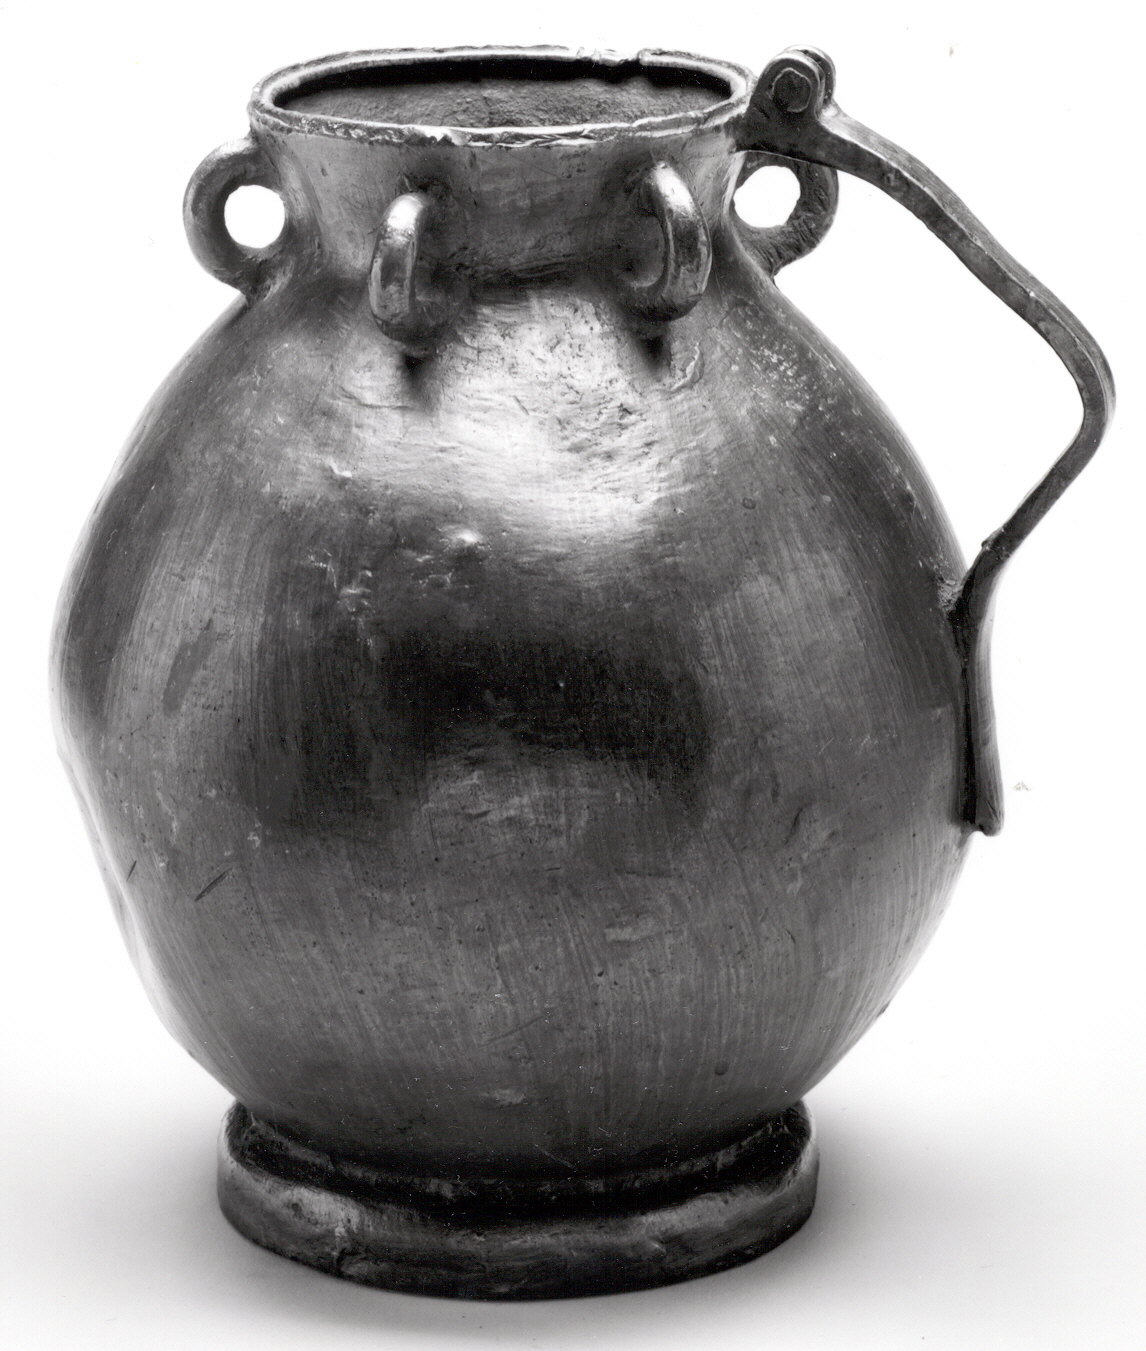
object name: vessel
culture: edo period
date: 1501-1900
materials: brass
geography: nigeria